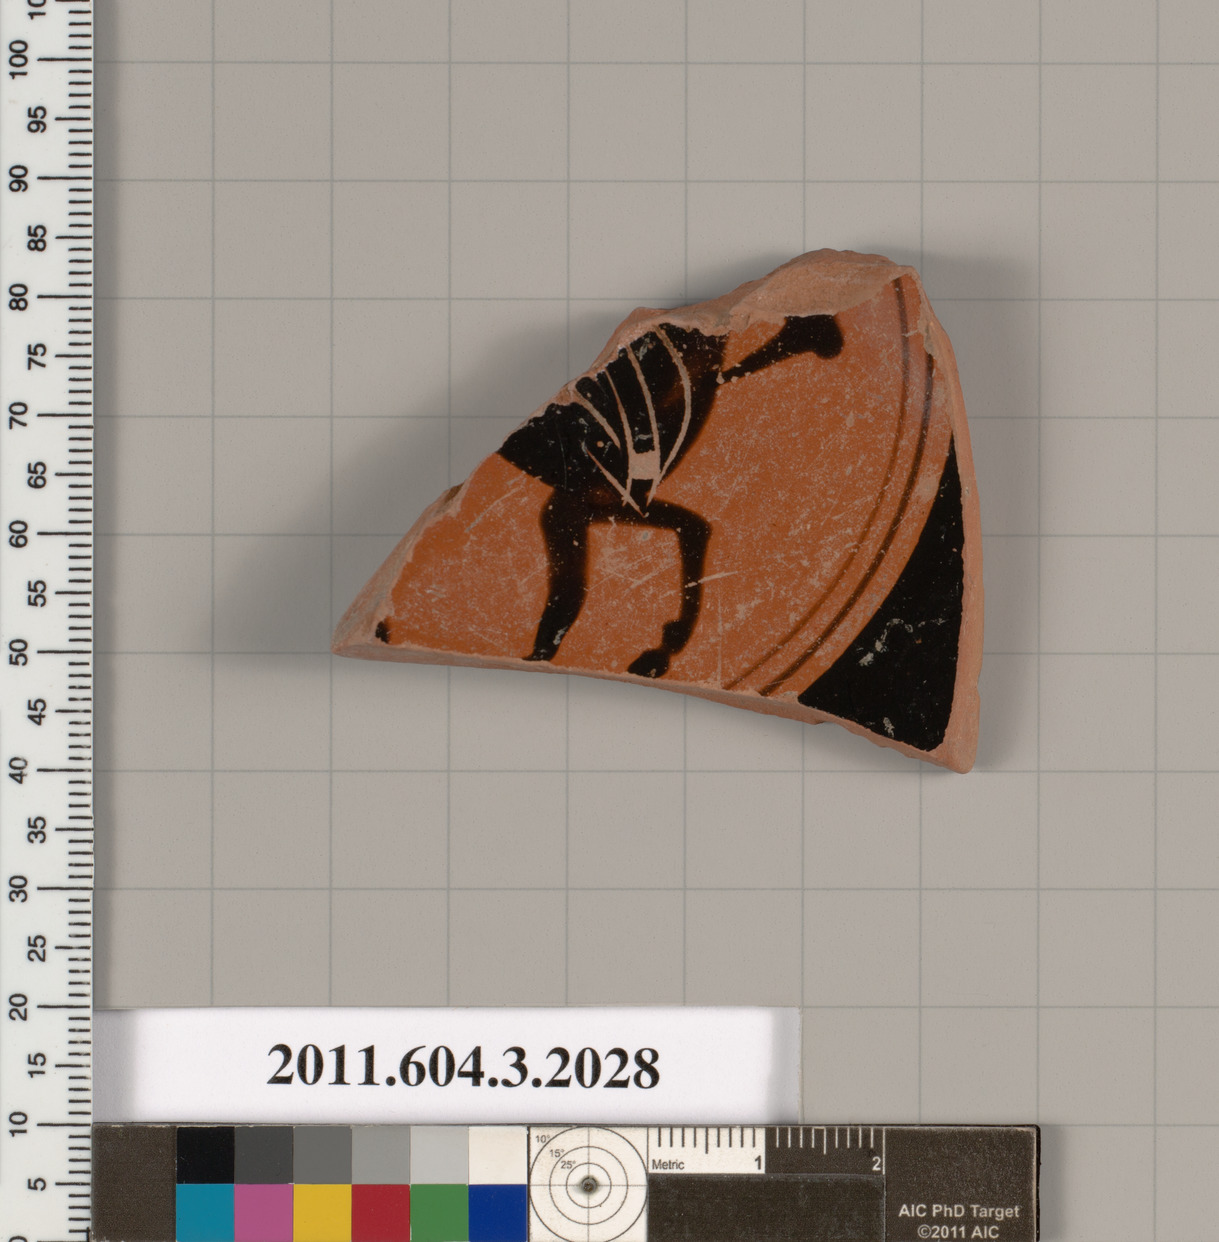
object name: kylix fragment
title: Terracotta fragment of a kylix (drinking cup)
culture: greek, attic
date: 534-468 BCE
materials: terracotta